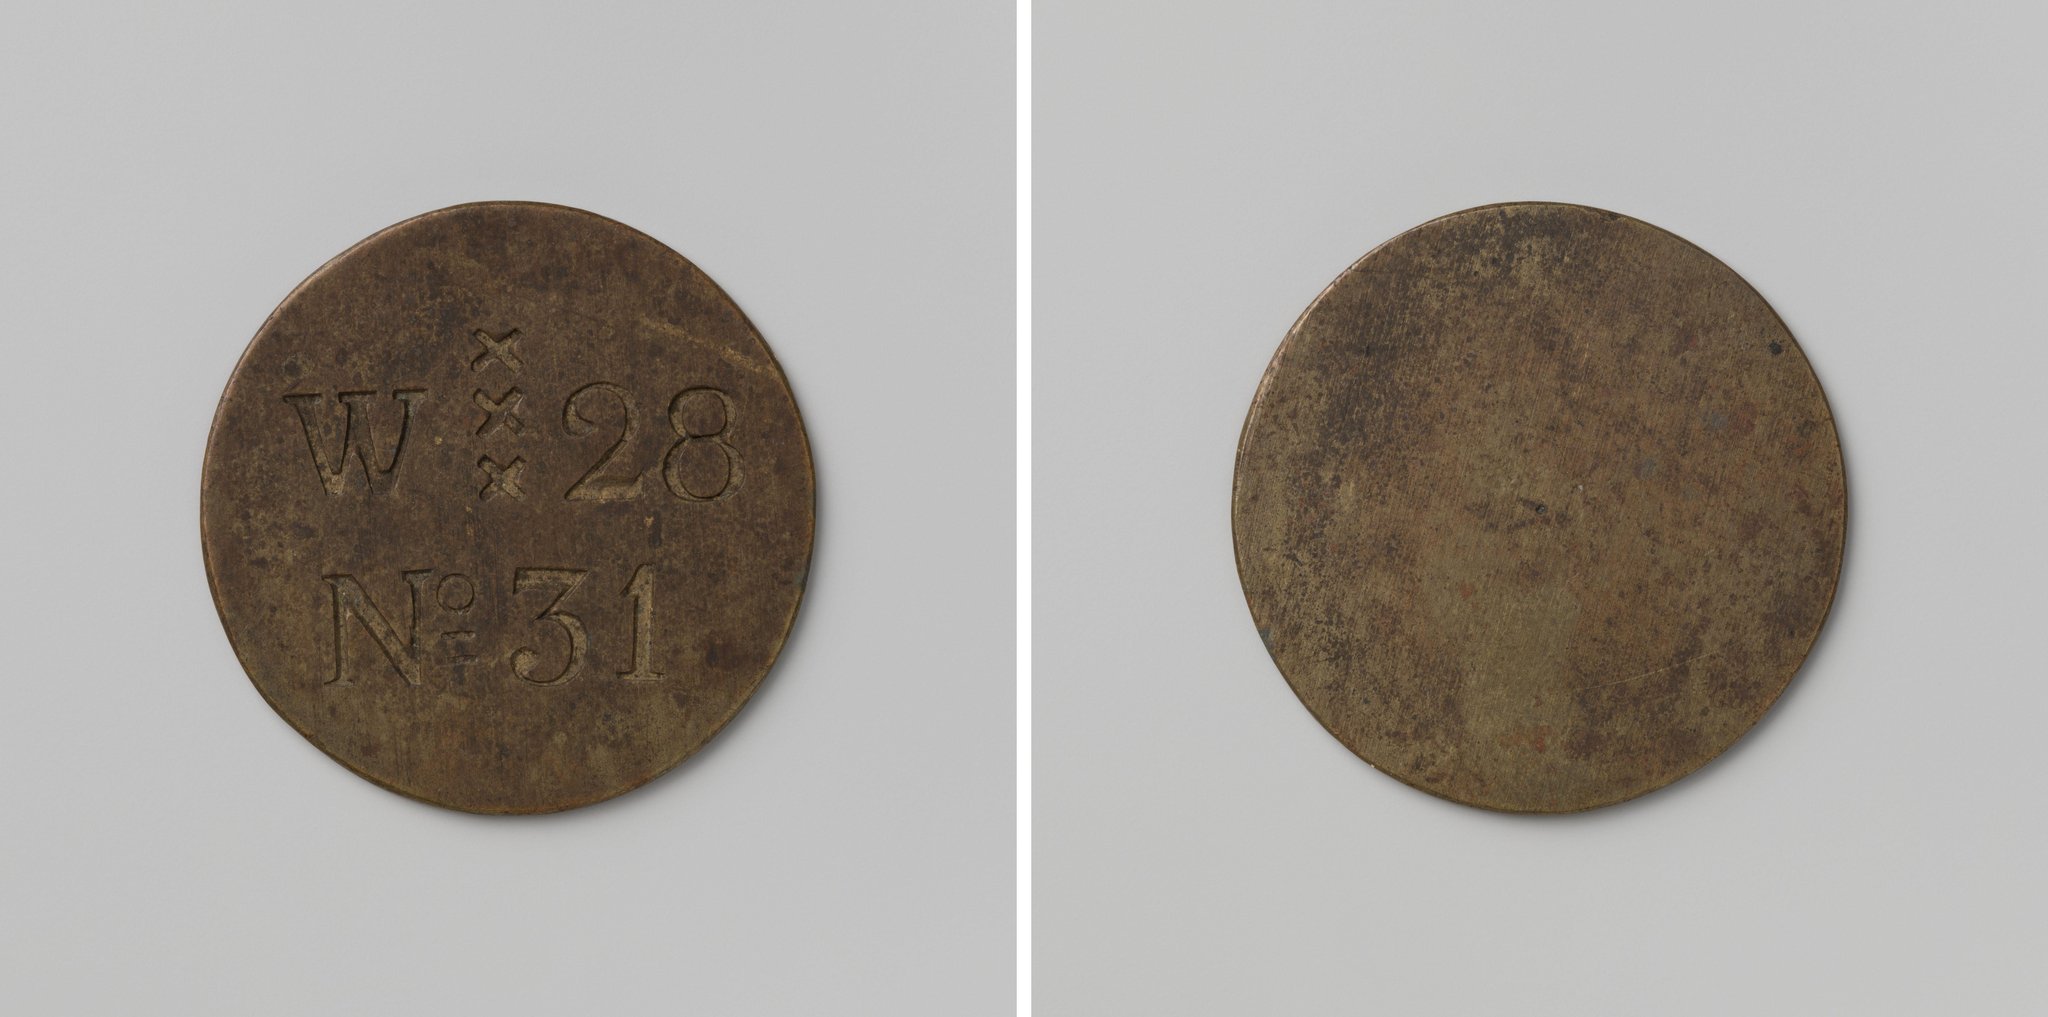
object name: fire engine medal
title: Amsterdam, brandspuitpenning van wijk 28 met no. 31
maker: Anonymous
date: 1831-1857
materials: brass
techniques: engraving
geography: amsterdam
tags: amsterdam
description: Eenzijdige messing penning. Voorzijde: opschrift W 28, onderbroken door drie boven elkaar geplaatste kruisjes; daaronder: opschrift No. 31. Keerzijde: blanco